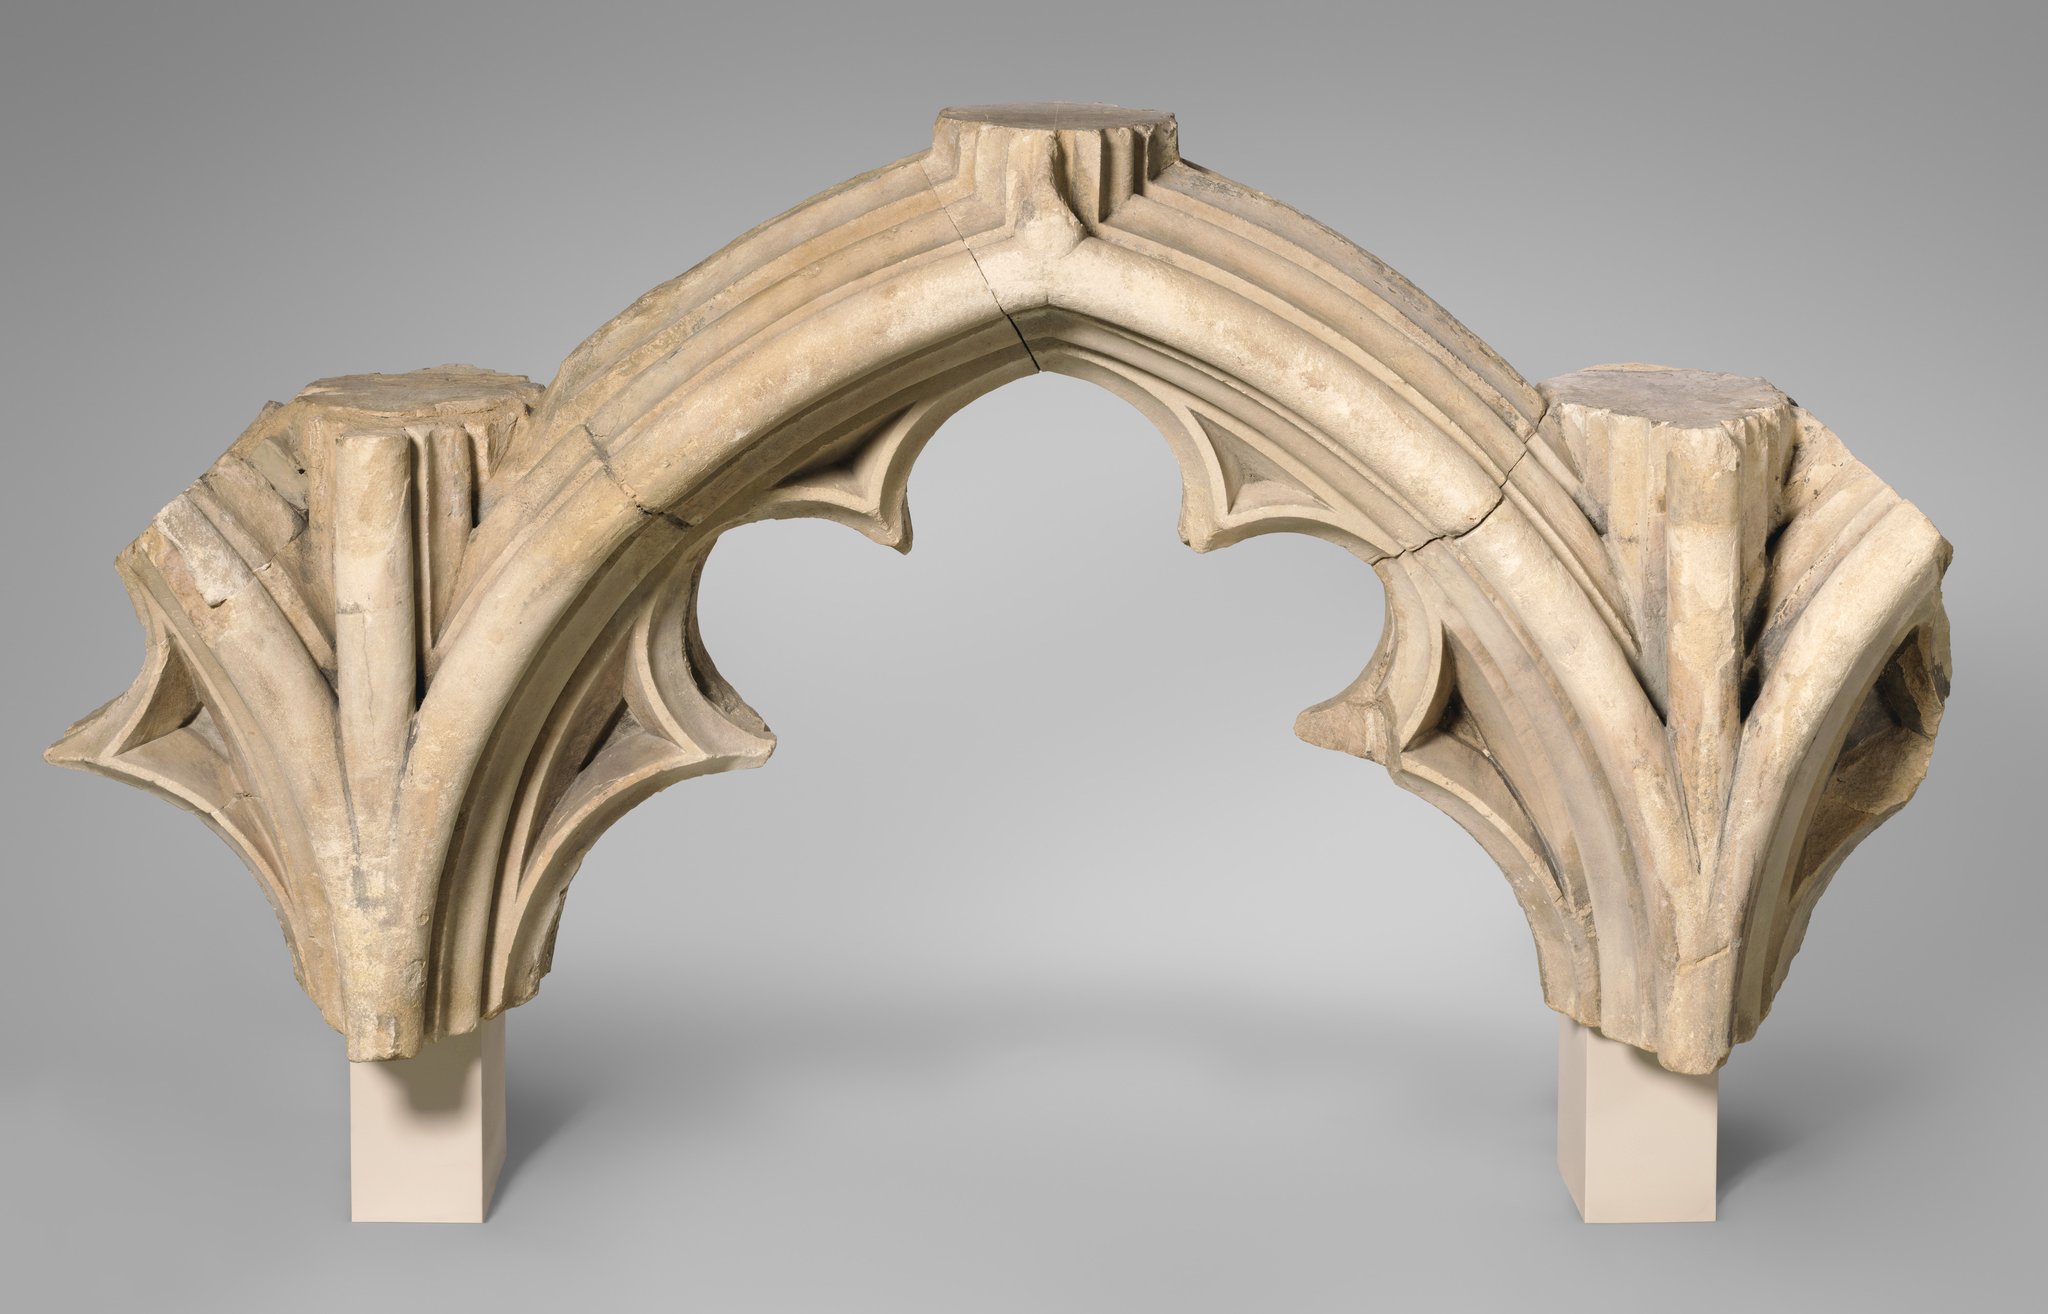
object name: architectural tracery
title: Tracery Arcade from the Great South Window of Canterbury Cathedral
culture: british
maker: master mason stephen lote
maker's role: artist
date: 1426-1435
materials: stone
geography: england